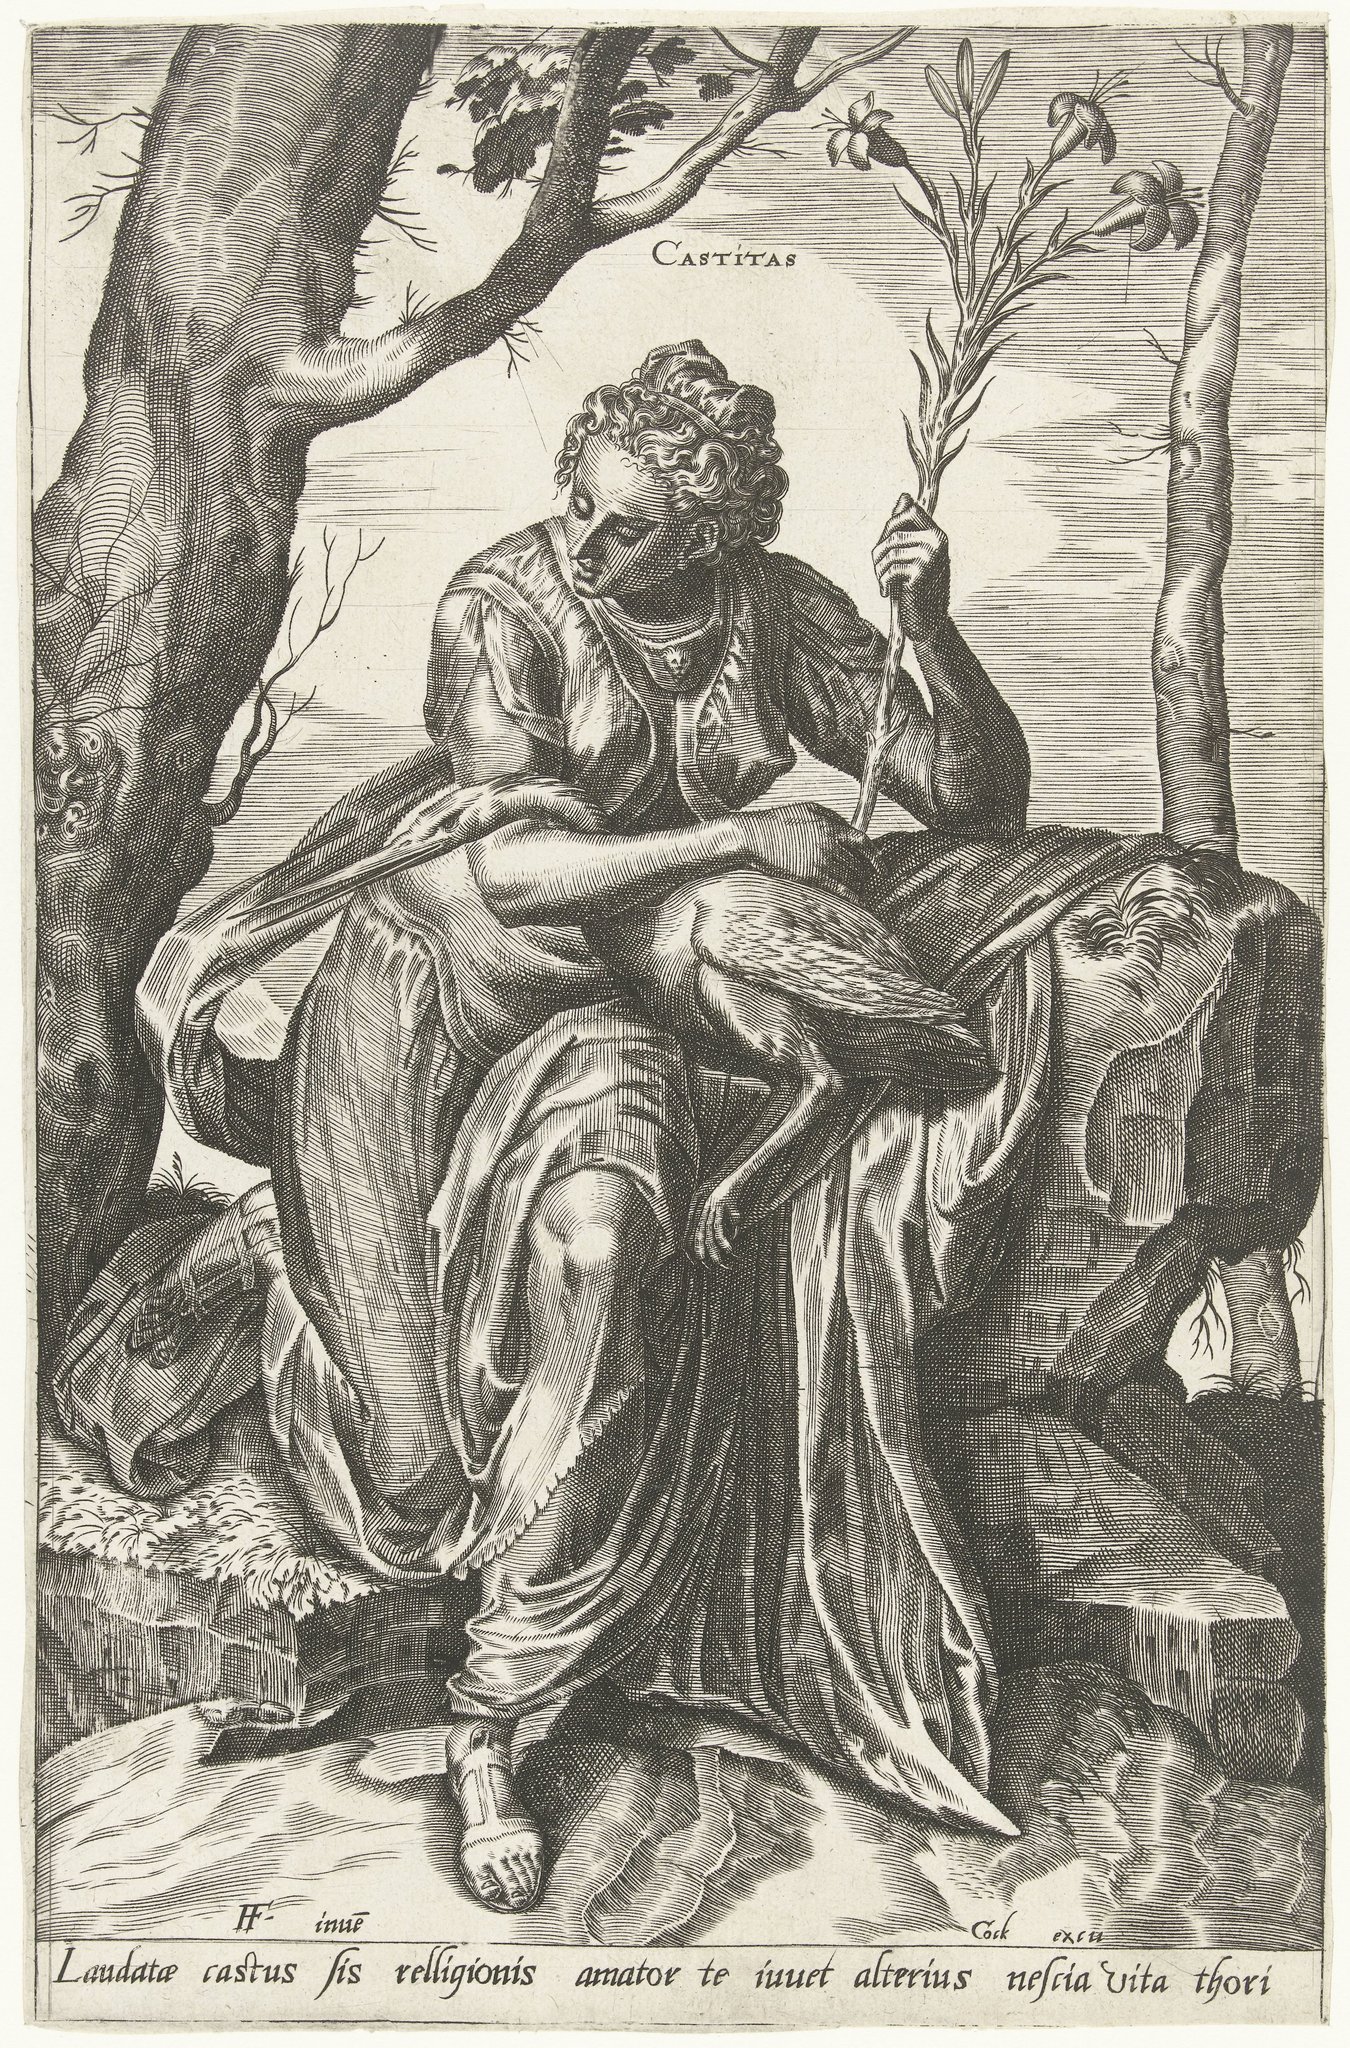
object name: print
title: Kuisheid (Castitas)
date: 1560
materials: paper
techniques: engraving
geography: antwerp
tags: 'castità ', 'pudicitia', 'vergogna honesta' (ripa)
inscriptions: collector's mark: Lugt 2760, collector's mark: Lugt 2228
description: De personificatie van de Kuisheid houdt een ooievaar en een lelie in haar handen. De lelie verwijst naar de kuisheid van de maagd Maria en ook de ooievaar staat symbool voor het weerstaan van de verzoeking.